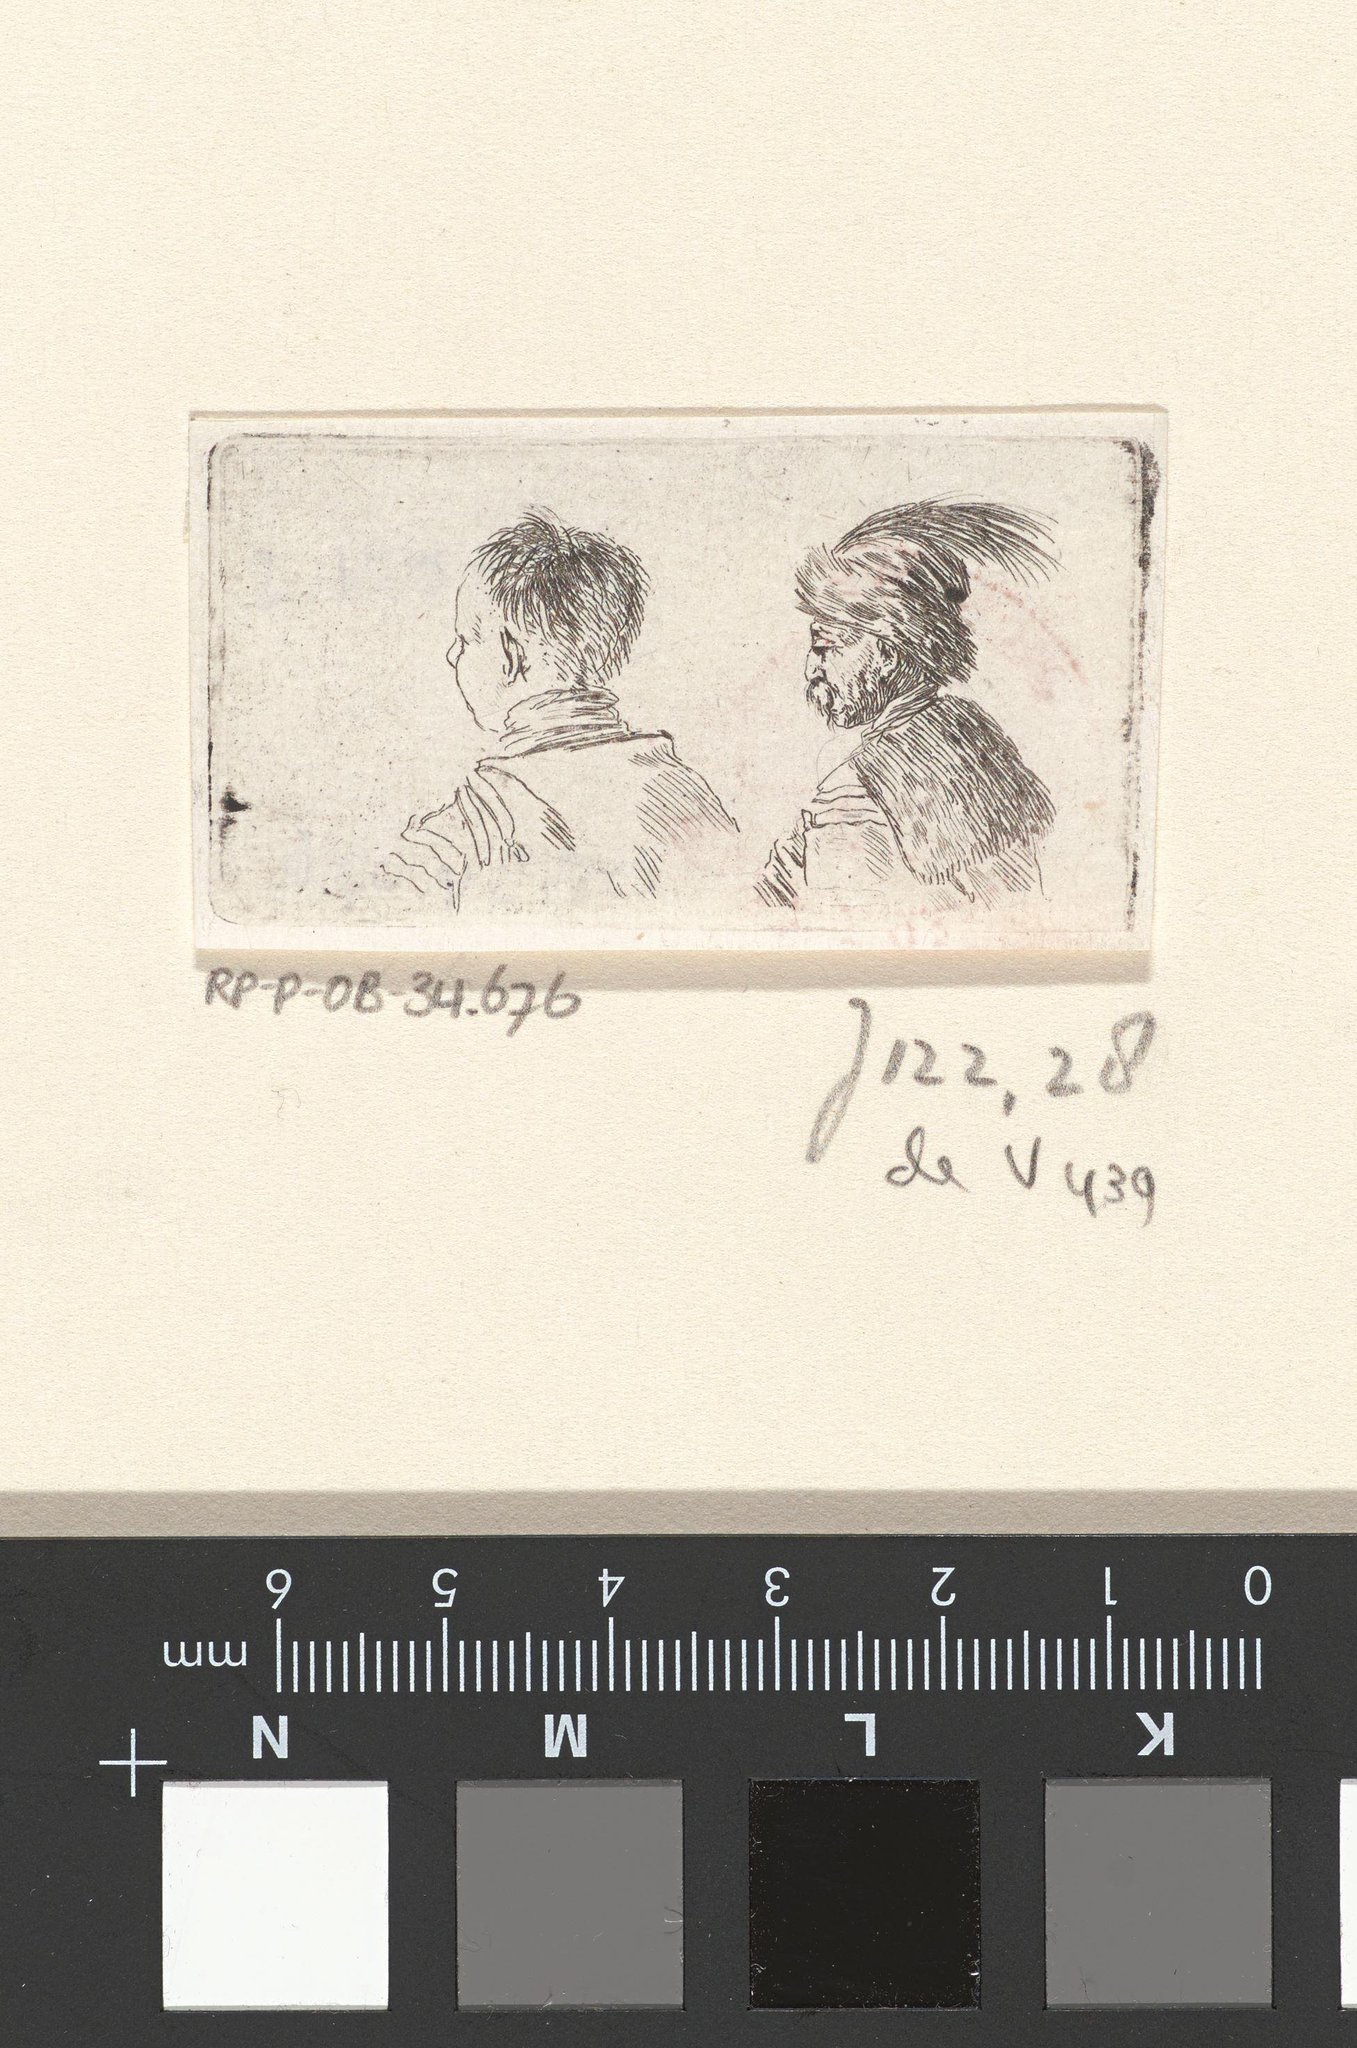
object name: print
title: Bustes van twee mannen, op de rug gezien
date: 1620-1664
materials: paper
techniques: etching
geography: france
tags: adult man (+ back view)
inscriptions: collector's mark: Lugt 240